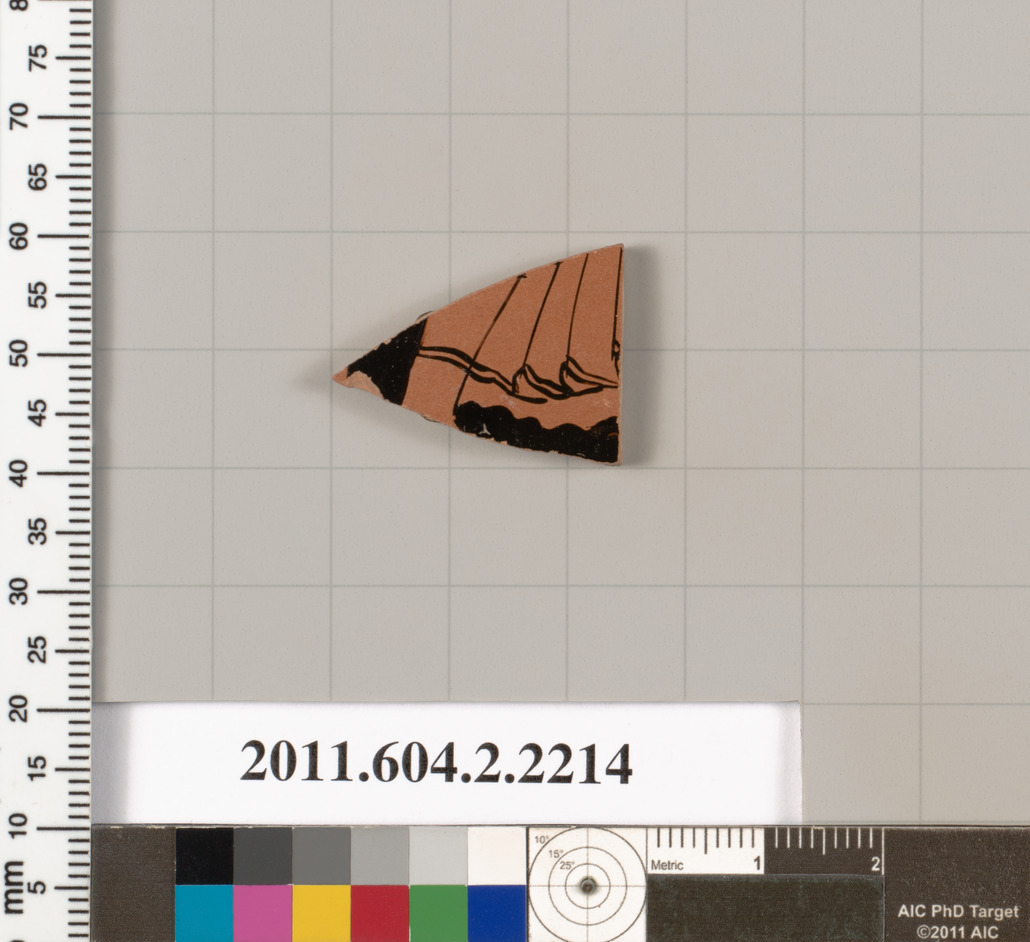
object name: pot fragment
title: Terracotta fragment of a pot; unglazed on the inside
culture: greek, attic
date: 475-451 BCE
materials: terracotta